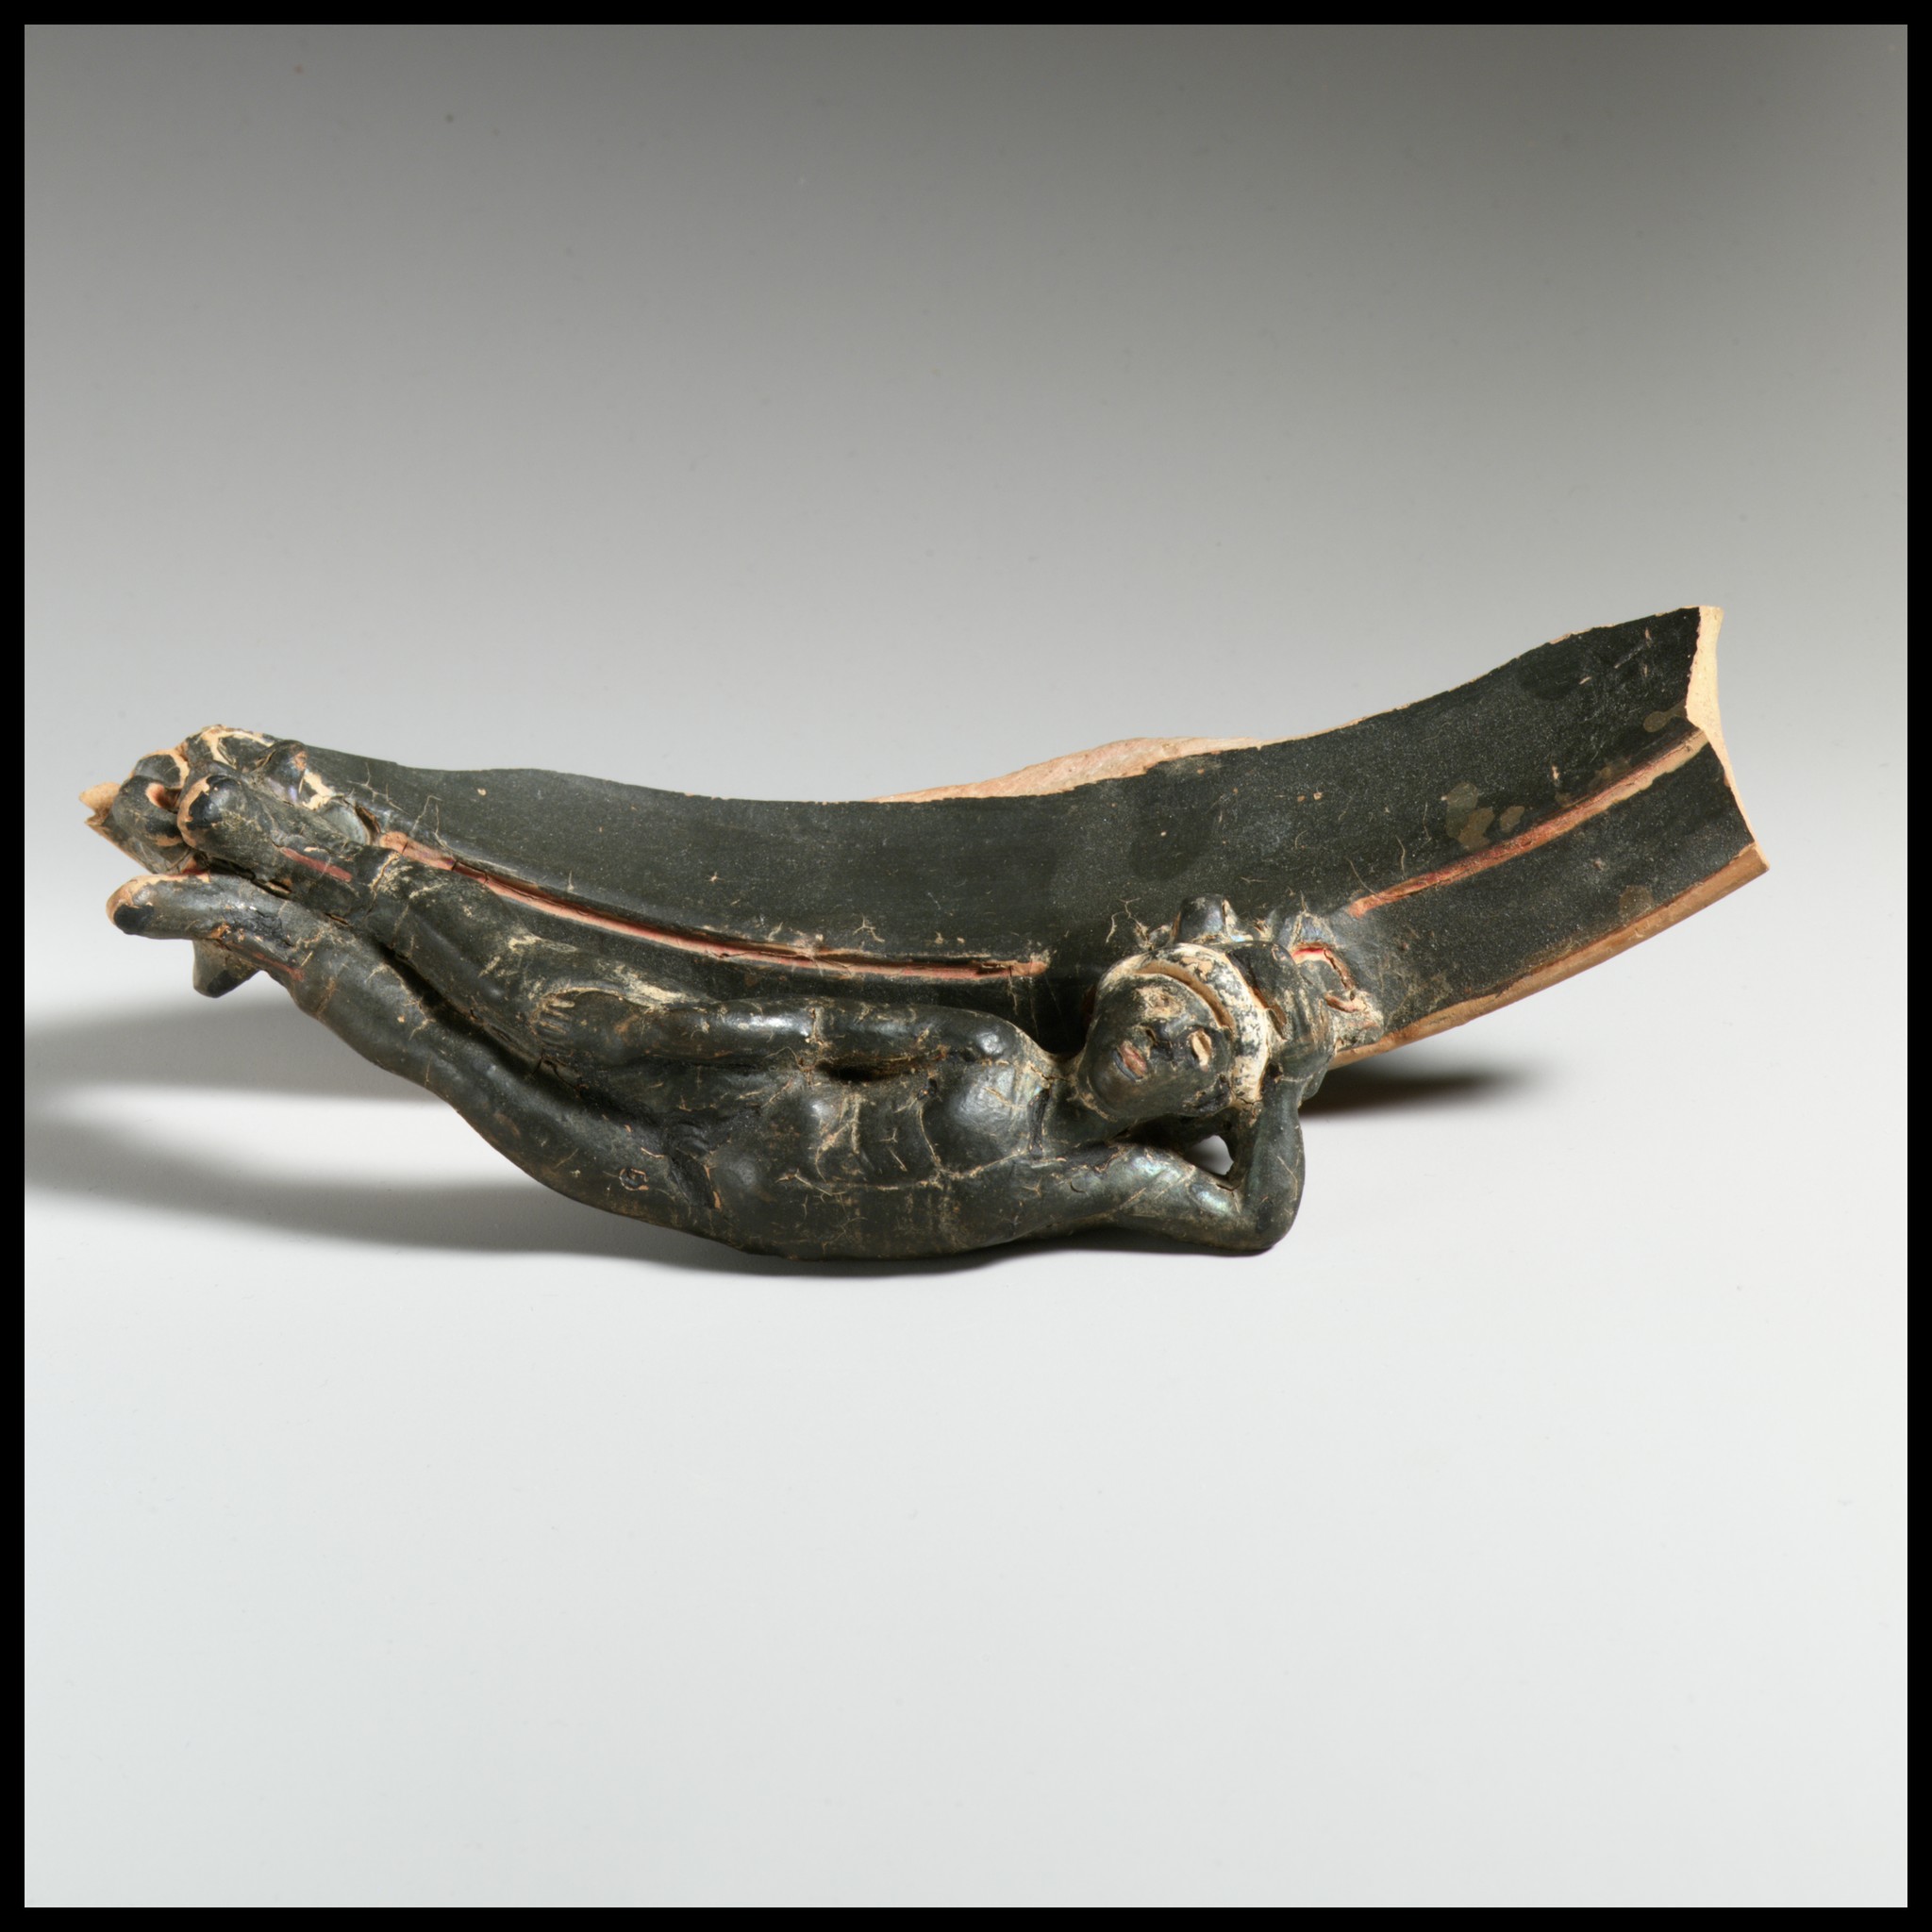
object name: handle fragment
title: Rim fragment of a large terracotta vessel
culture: etruscan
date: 300-201 BCE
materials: terracotta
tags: human figures,sleeping